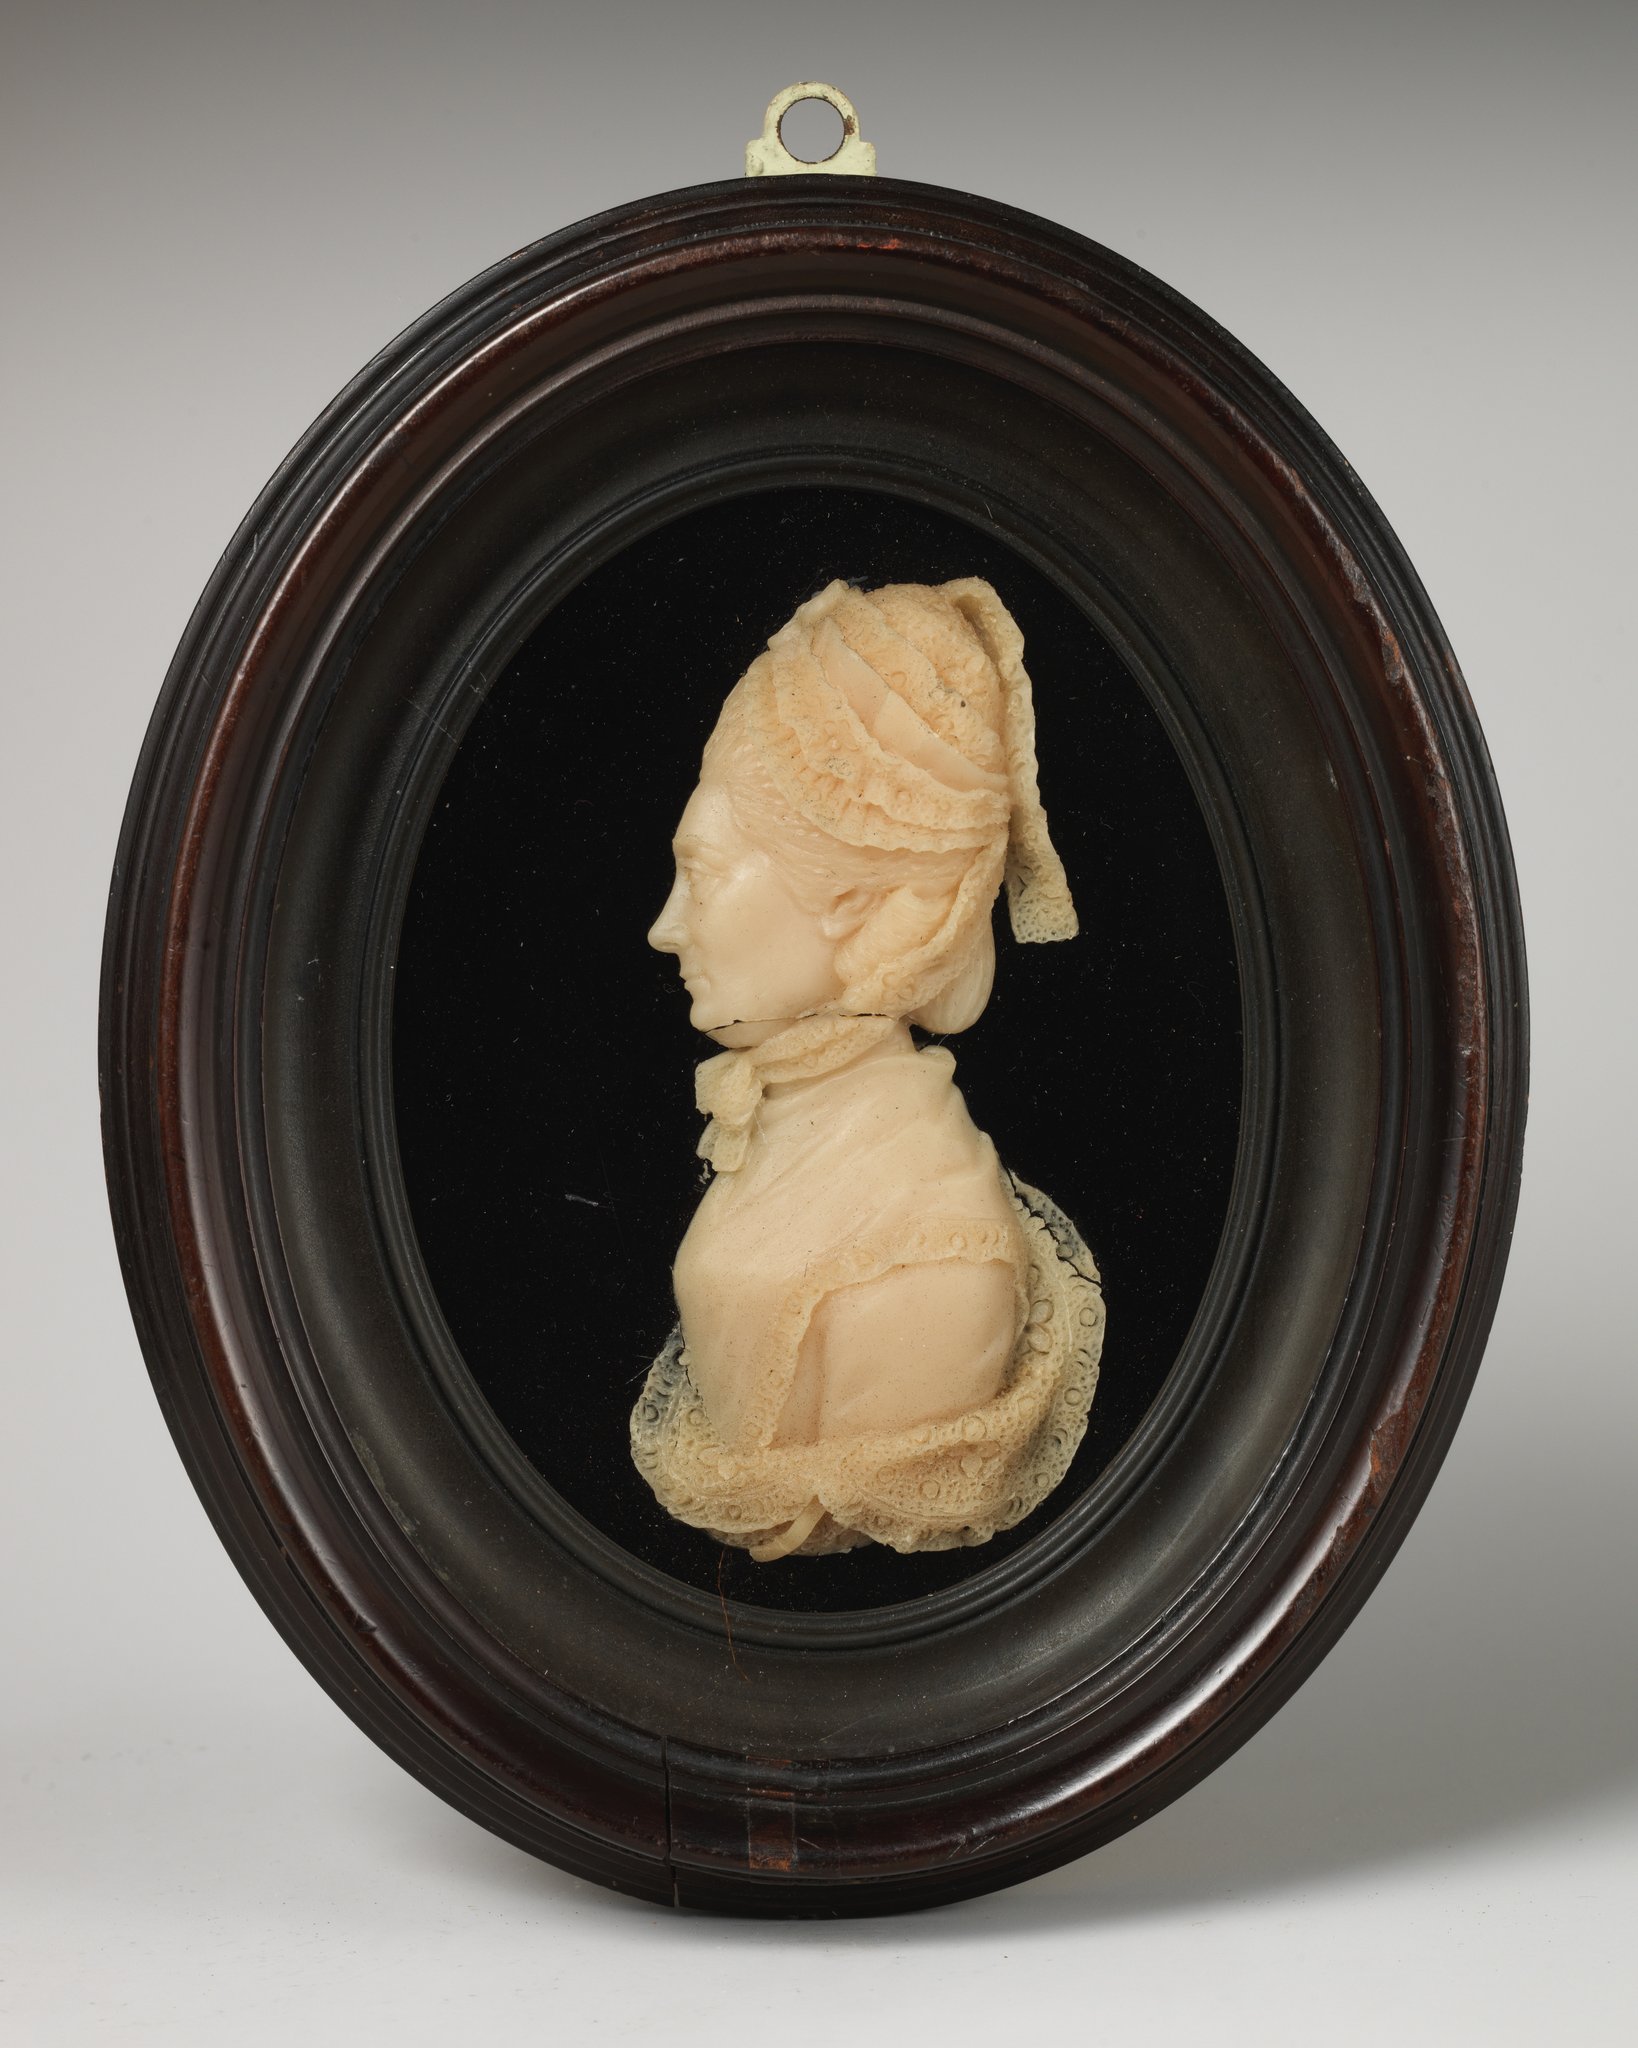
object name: medallion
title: Mrs. Robertson (Margaret Berry), 1720–1795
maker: thomas engleheart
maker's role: artist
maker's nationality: british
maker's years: 1745-1786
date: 1785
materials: glass, wax, wood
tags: profiles,women